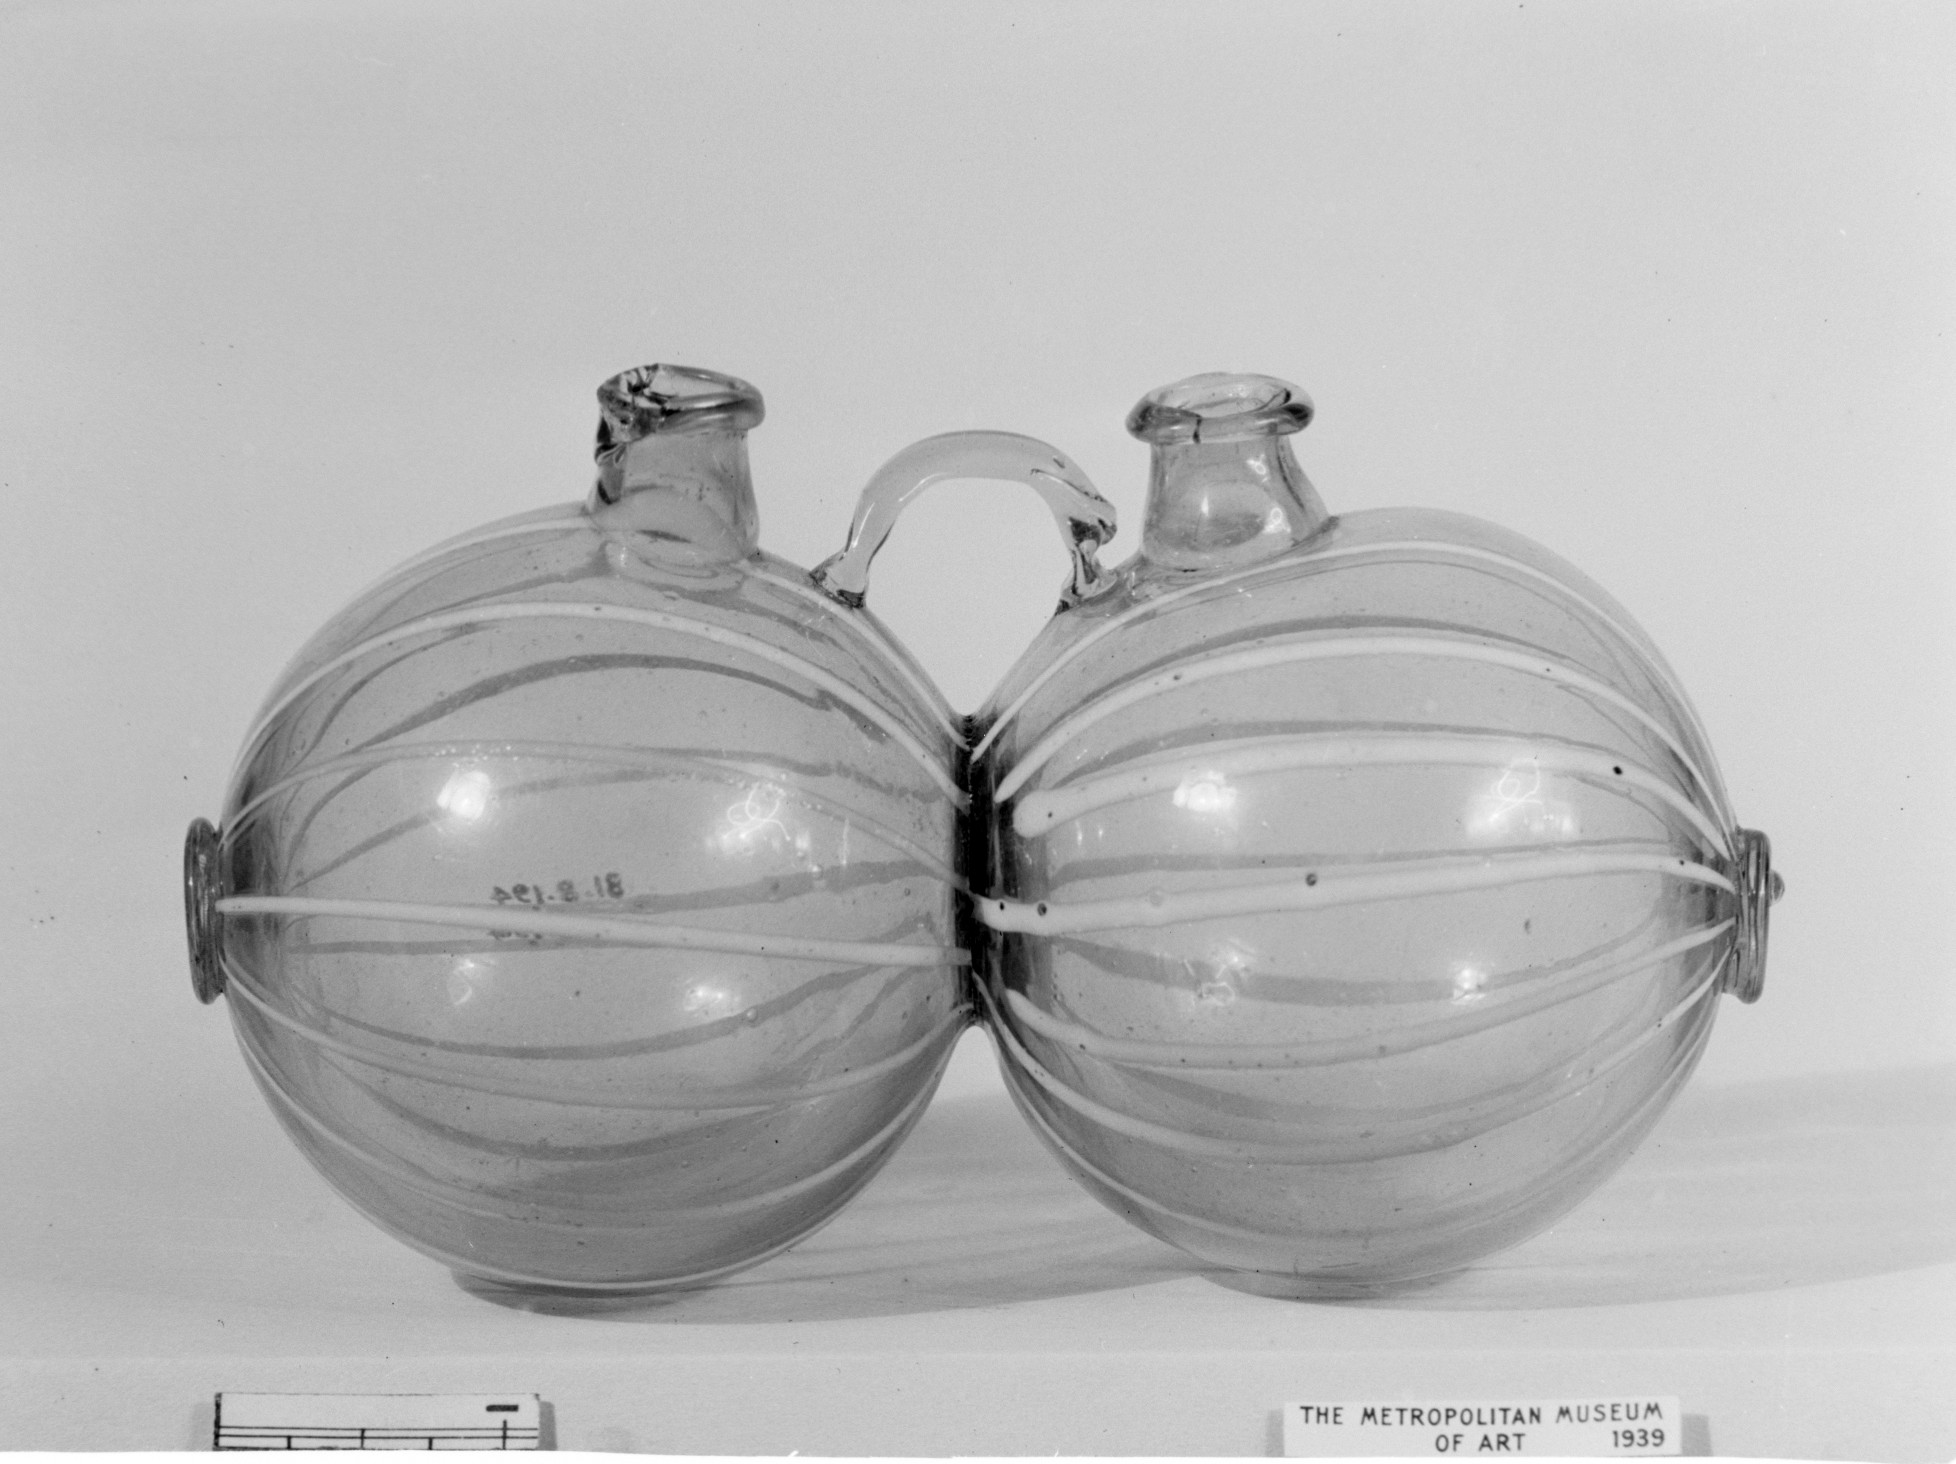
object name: double flask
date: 1601-1700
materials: glass